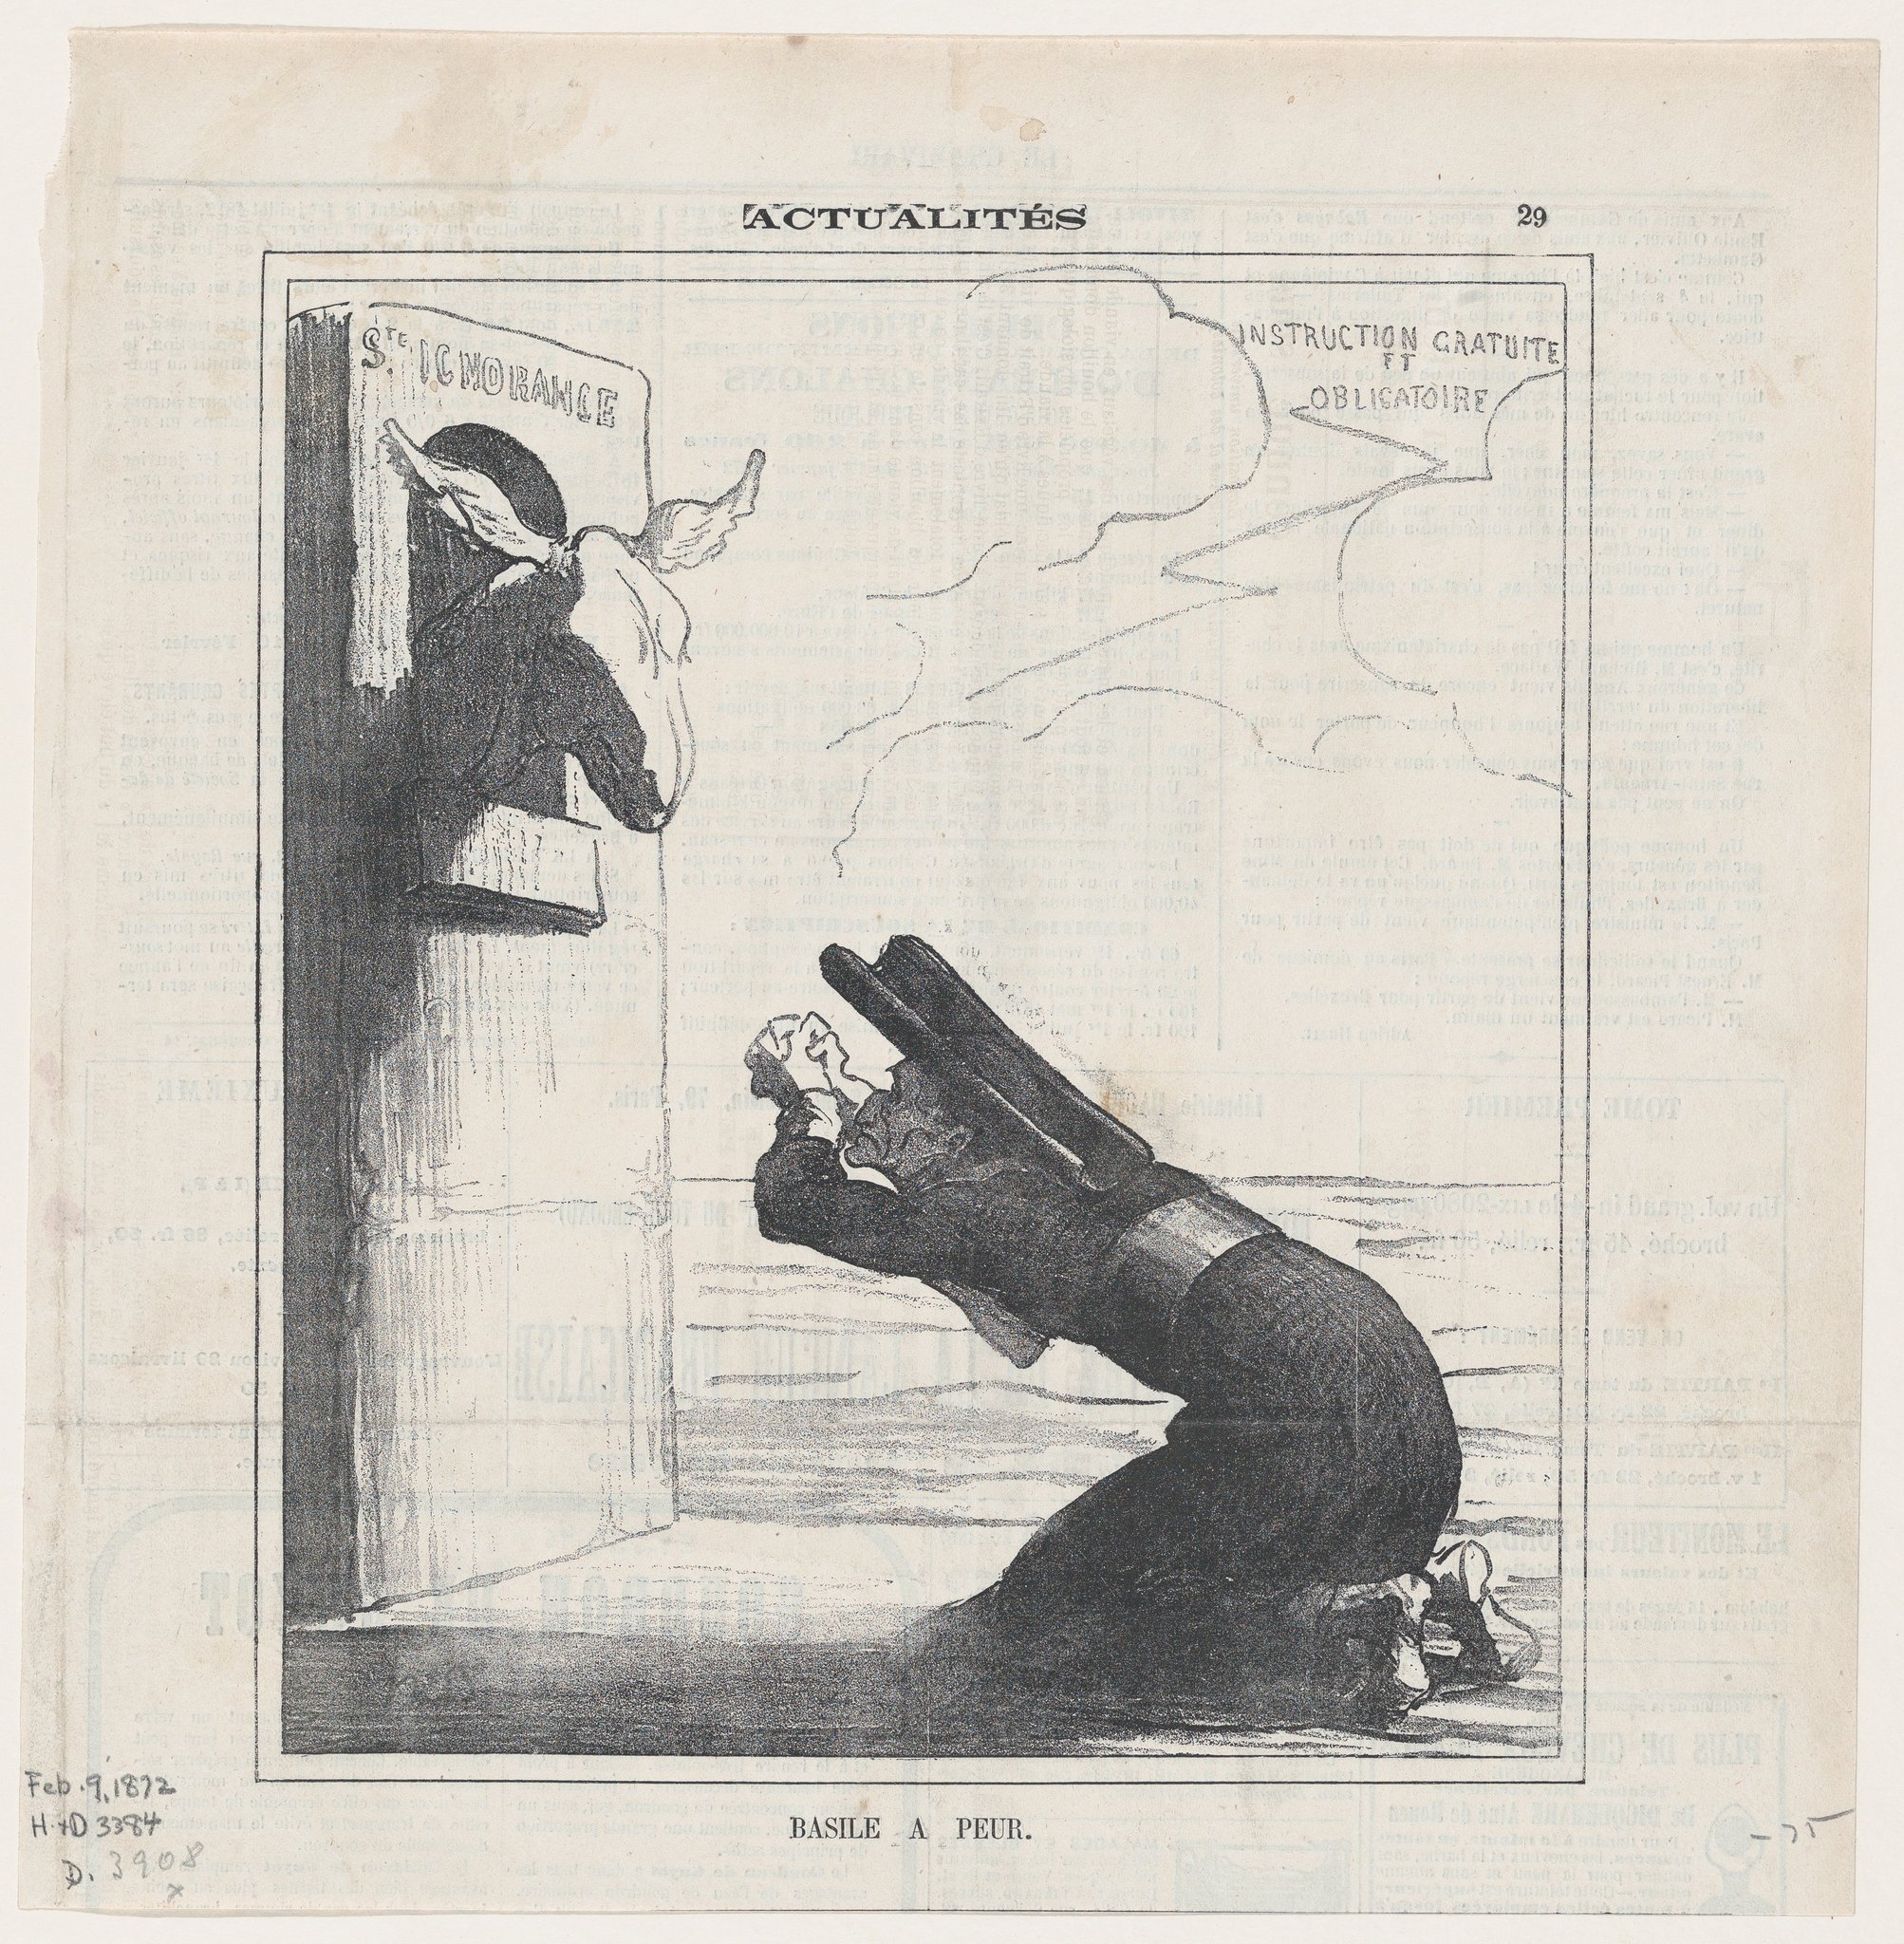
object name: print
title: Basile in fear, from 'News of the day,' published in Le Charivari, February 9, 1872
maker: honoré daumier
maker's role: artist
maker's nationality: french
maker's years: 1808-1879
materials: paper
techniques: lithograph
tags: animals,satire,men